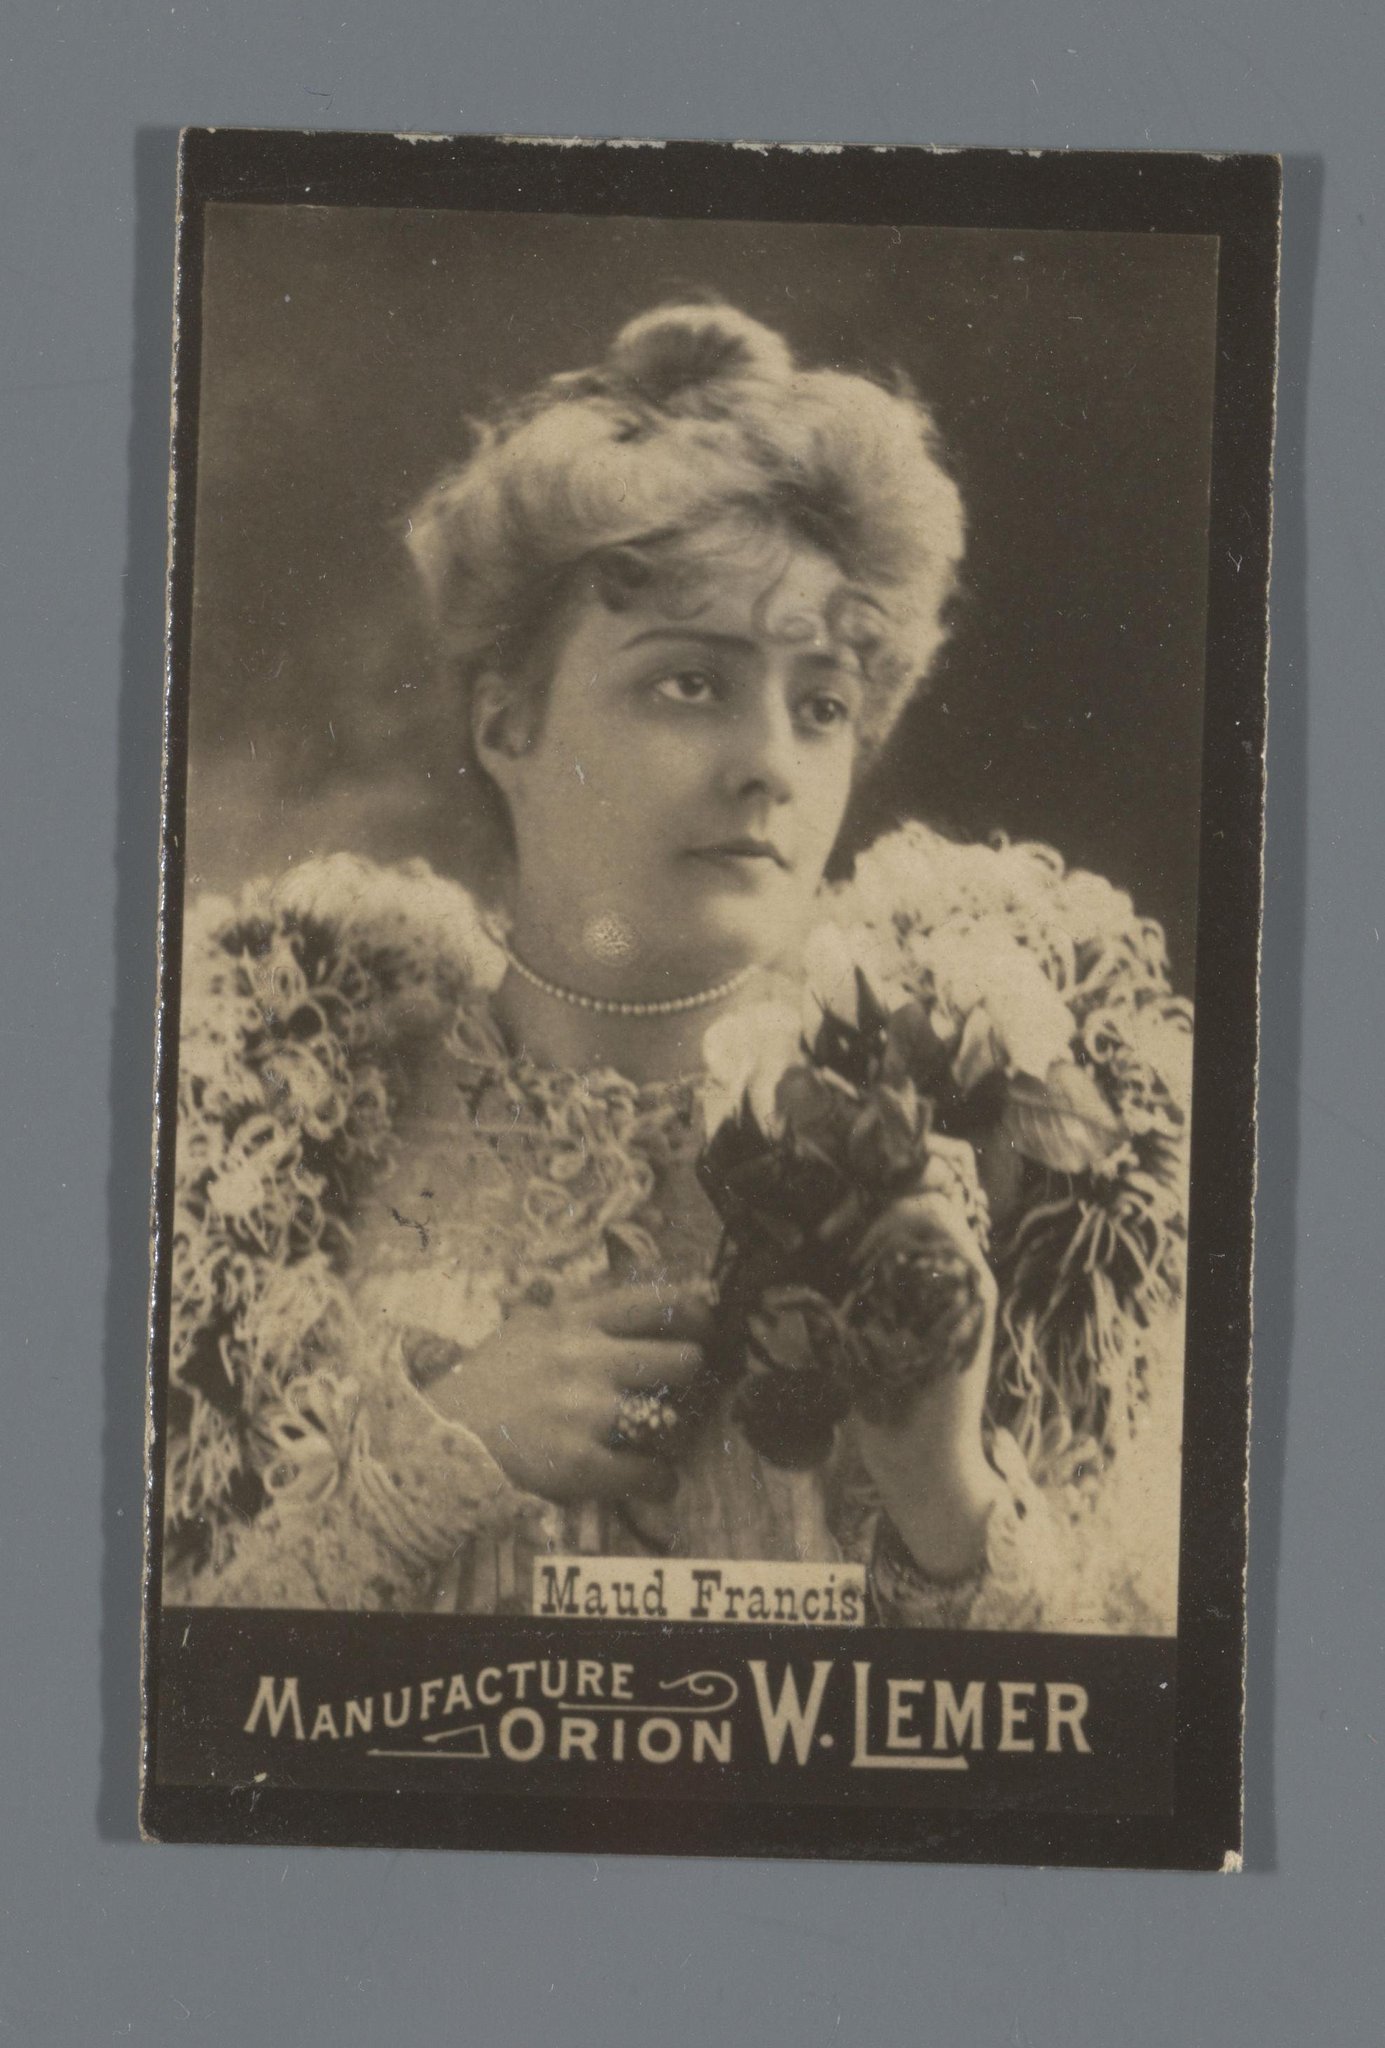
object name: photograph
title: Maud Francis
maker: Anonymous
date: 1895-1910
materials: paper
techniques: gelatin silver print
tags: adult woman, historical persons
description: Dergelijke foto's stonden bekend als 'zwartjes'. Men verkreeg ze bij aanschaf van bepaalde merken thee, cacao, sigaretten, beschuit, etc. om te verzamelen. Er waren speciaal voor de 'zwartjes' verzamelalbums in omloop.